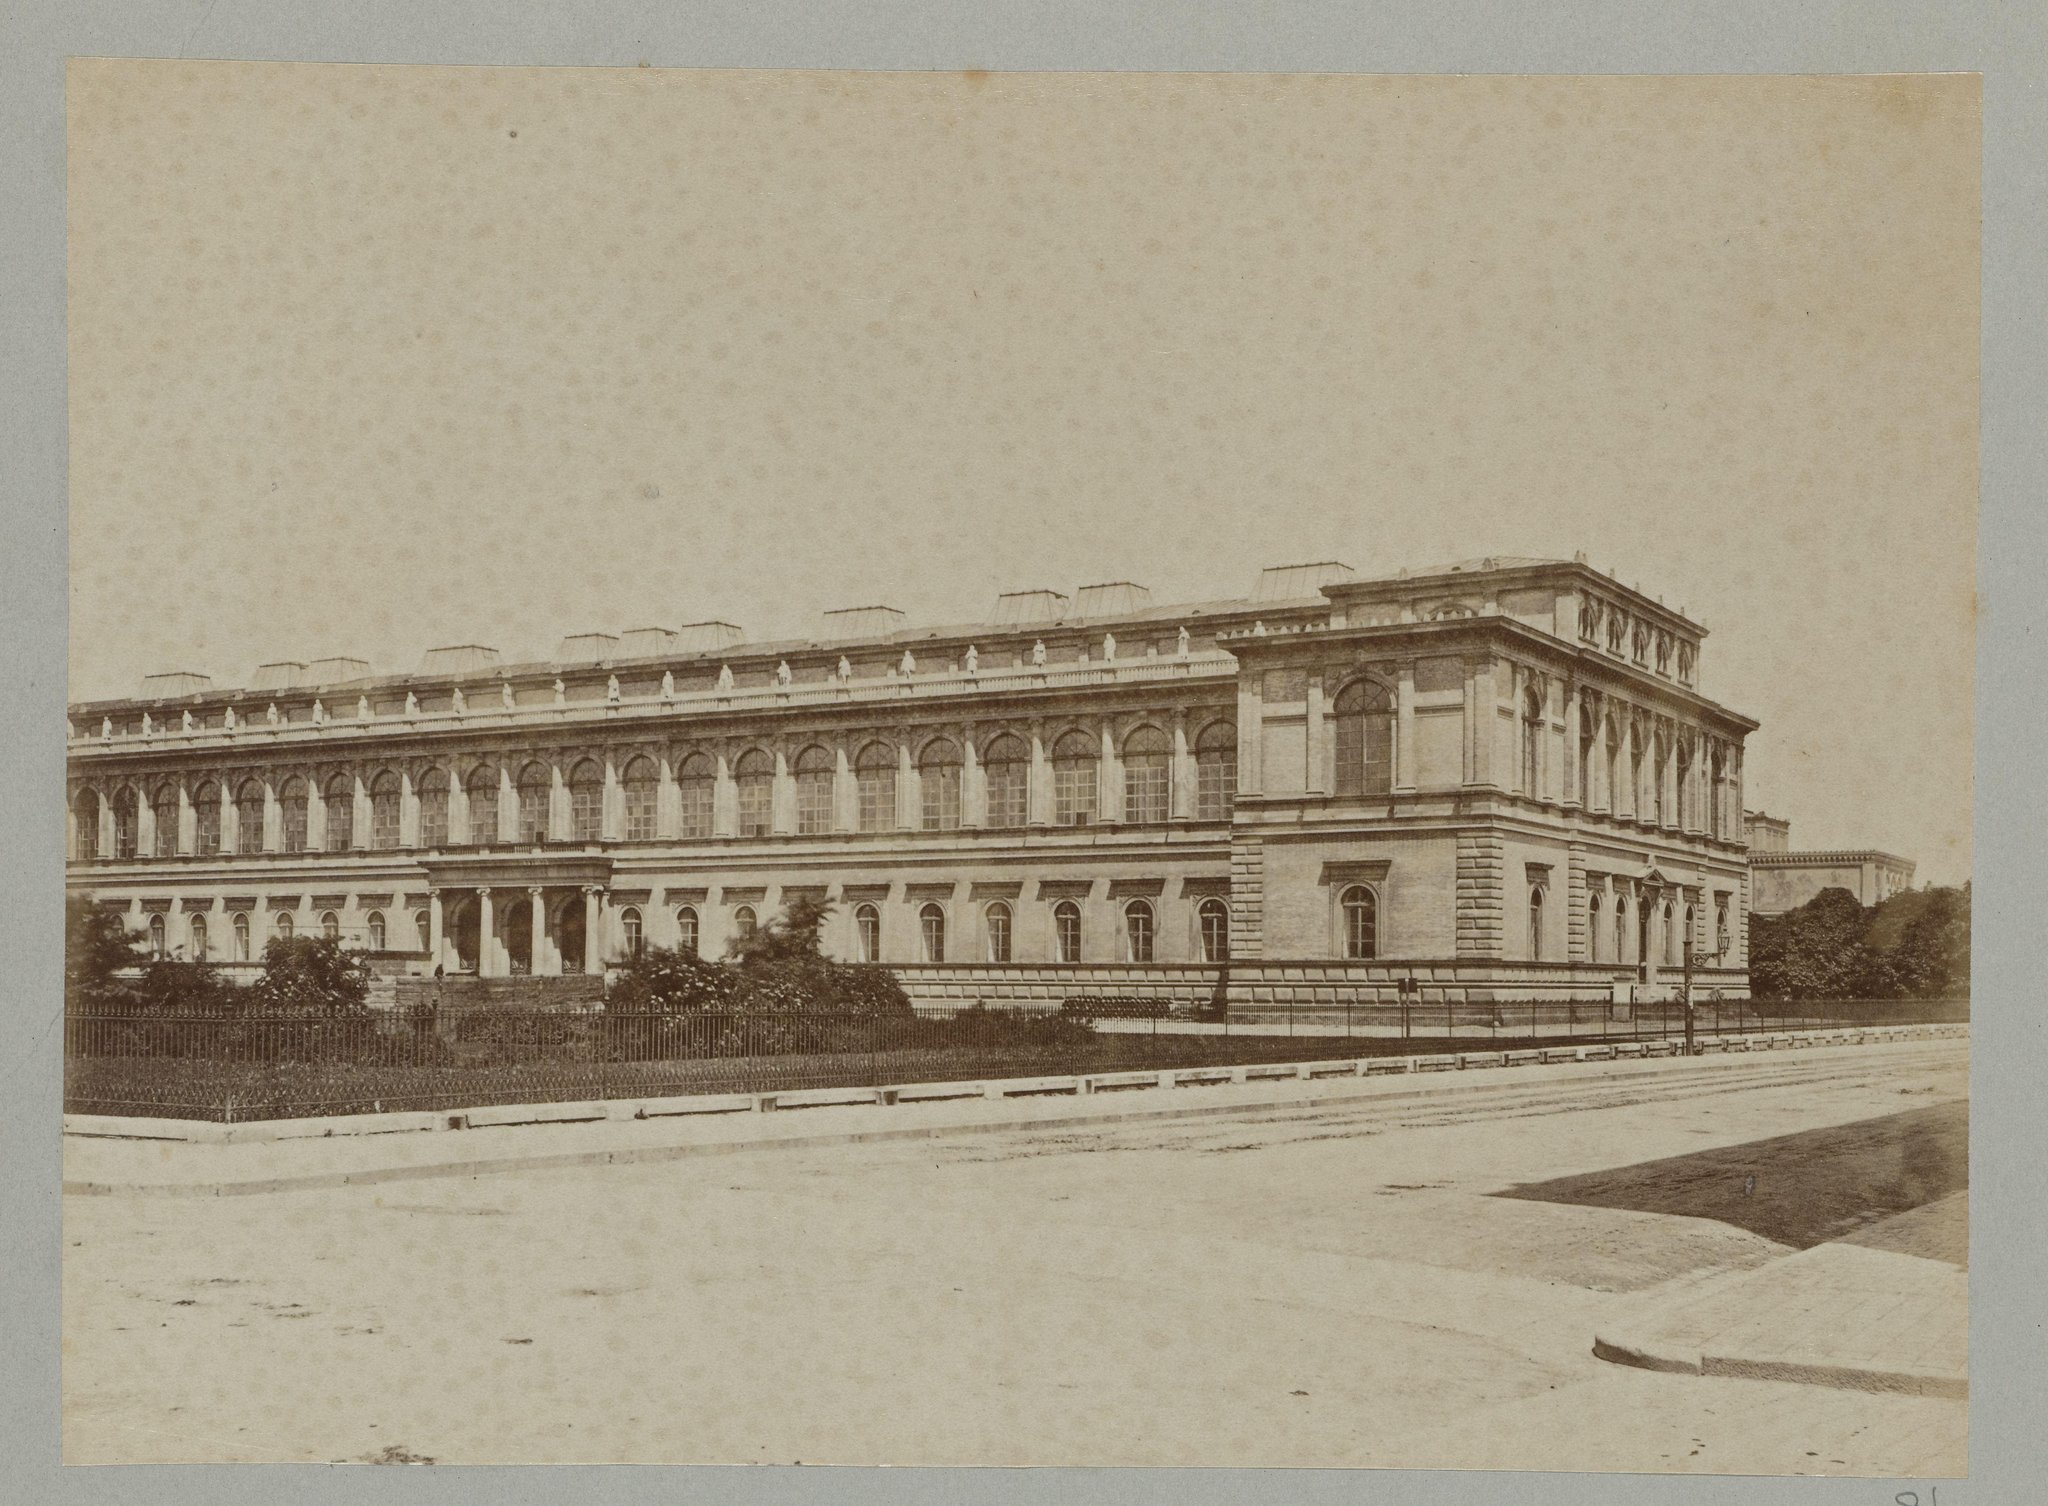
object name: photograph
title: München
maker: Anonymous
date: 1893-1903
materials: cardboard, photographic support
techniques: albumen print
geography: munich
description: De Alte Pinakothek Munchen ontworpen door Leo von Klenze.